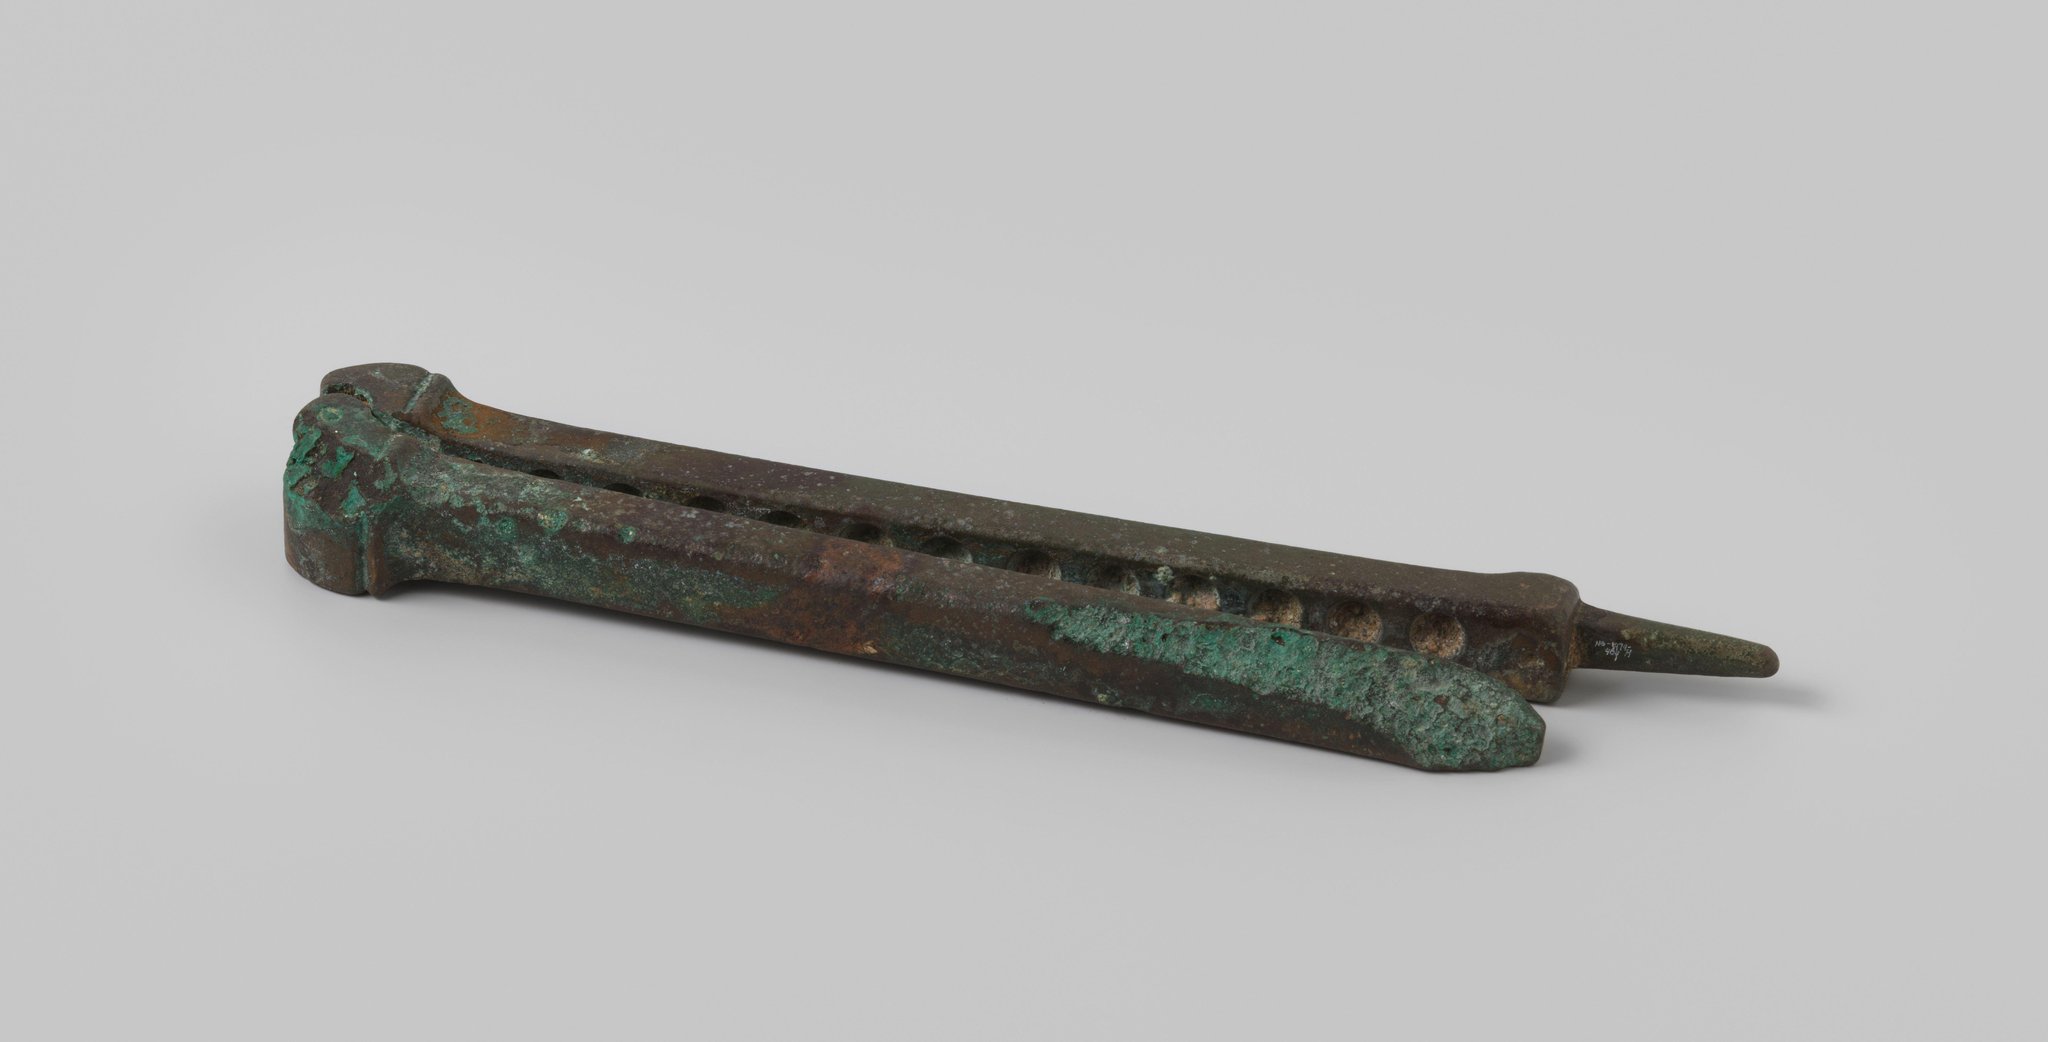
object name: bullet mould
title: Giettang voor musketkogels uit het wrak van de Oost-Indiëvaarder Hollandia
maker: Anonymous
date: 1700-1743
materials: copper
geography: netherlands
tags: verenigde oostindische compagnie, hollandia (schip), annet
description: Shotmould; id. NG 1975-45H, eroded, one tang missing. Gemerkt: XXIIII.